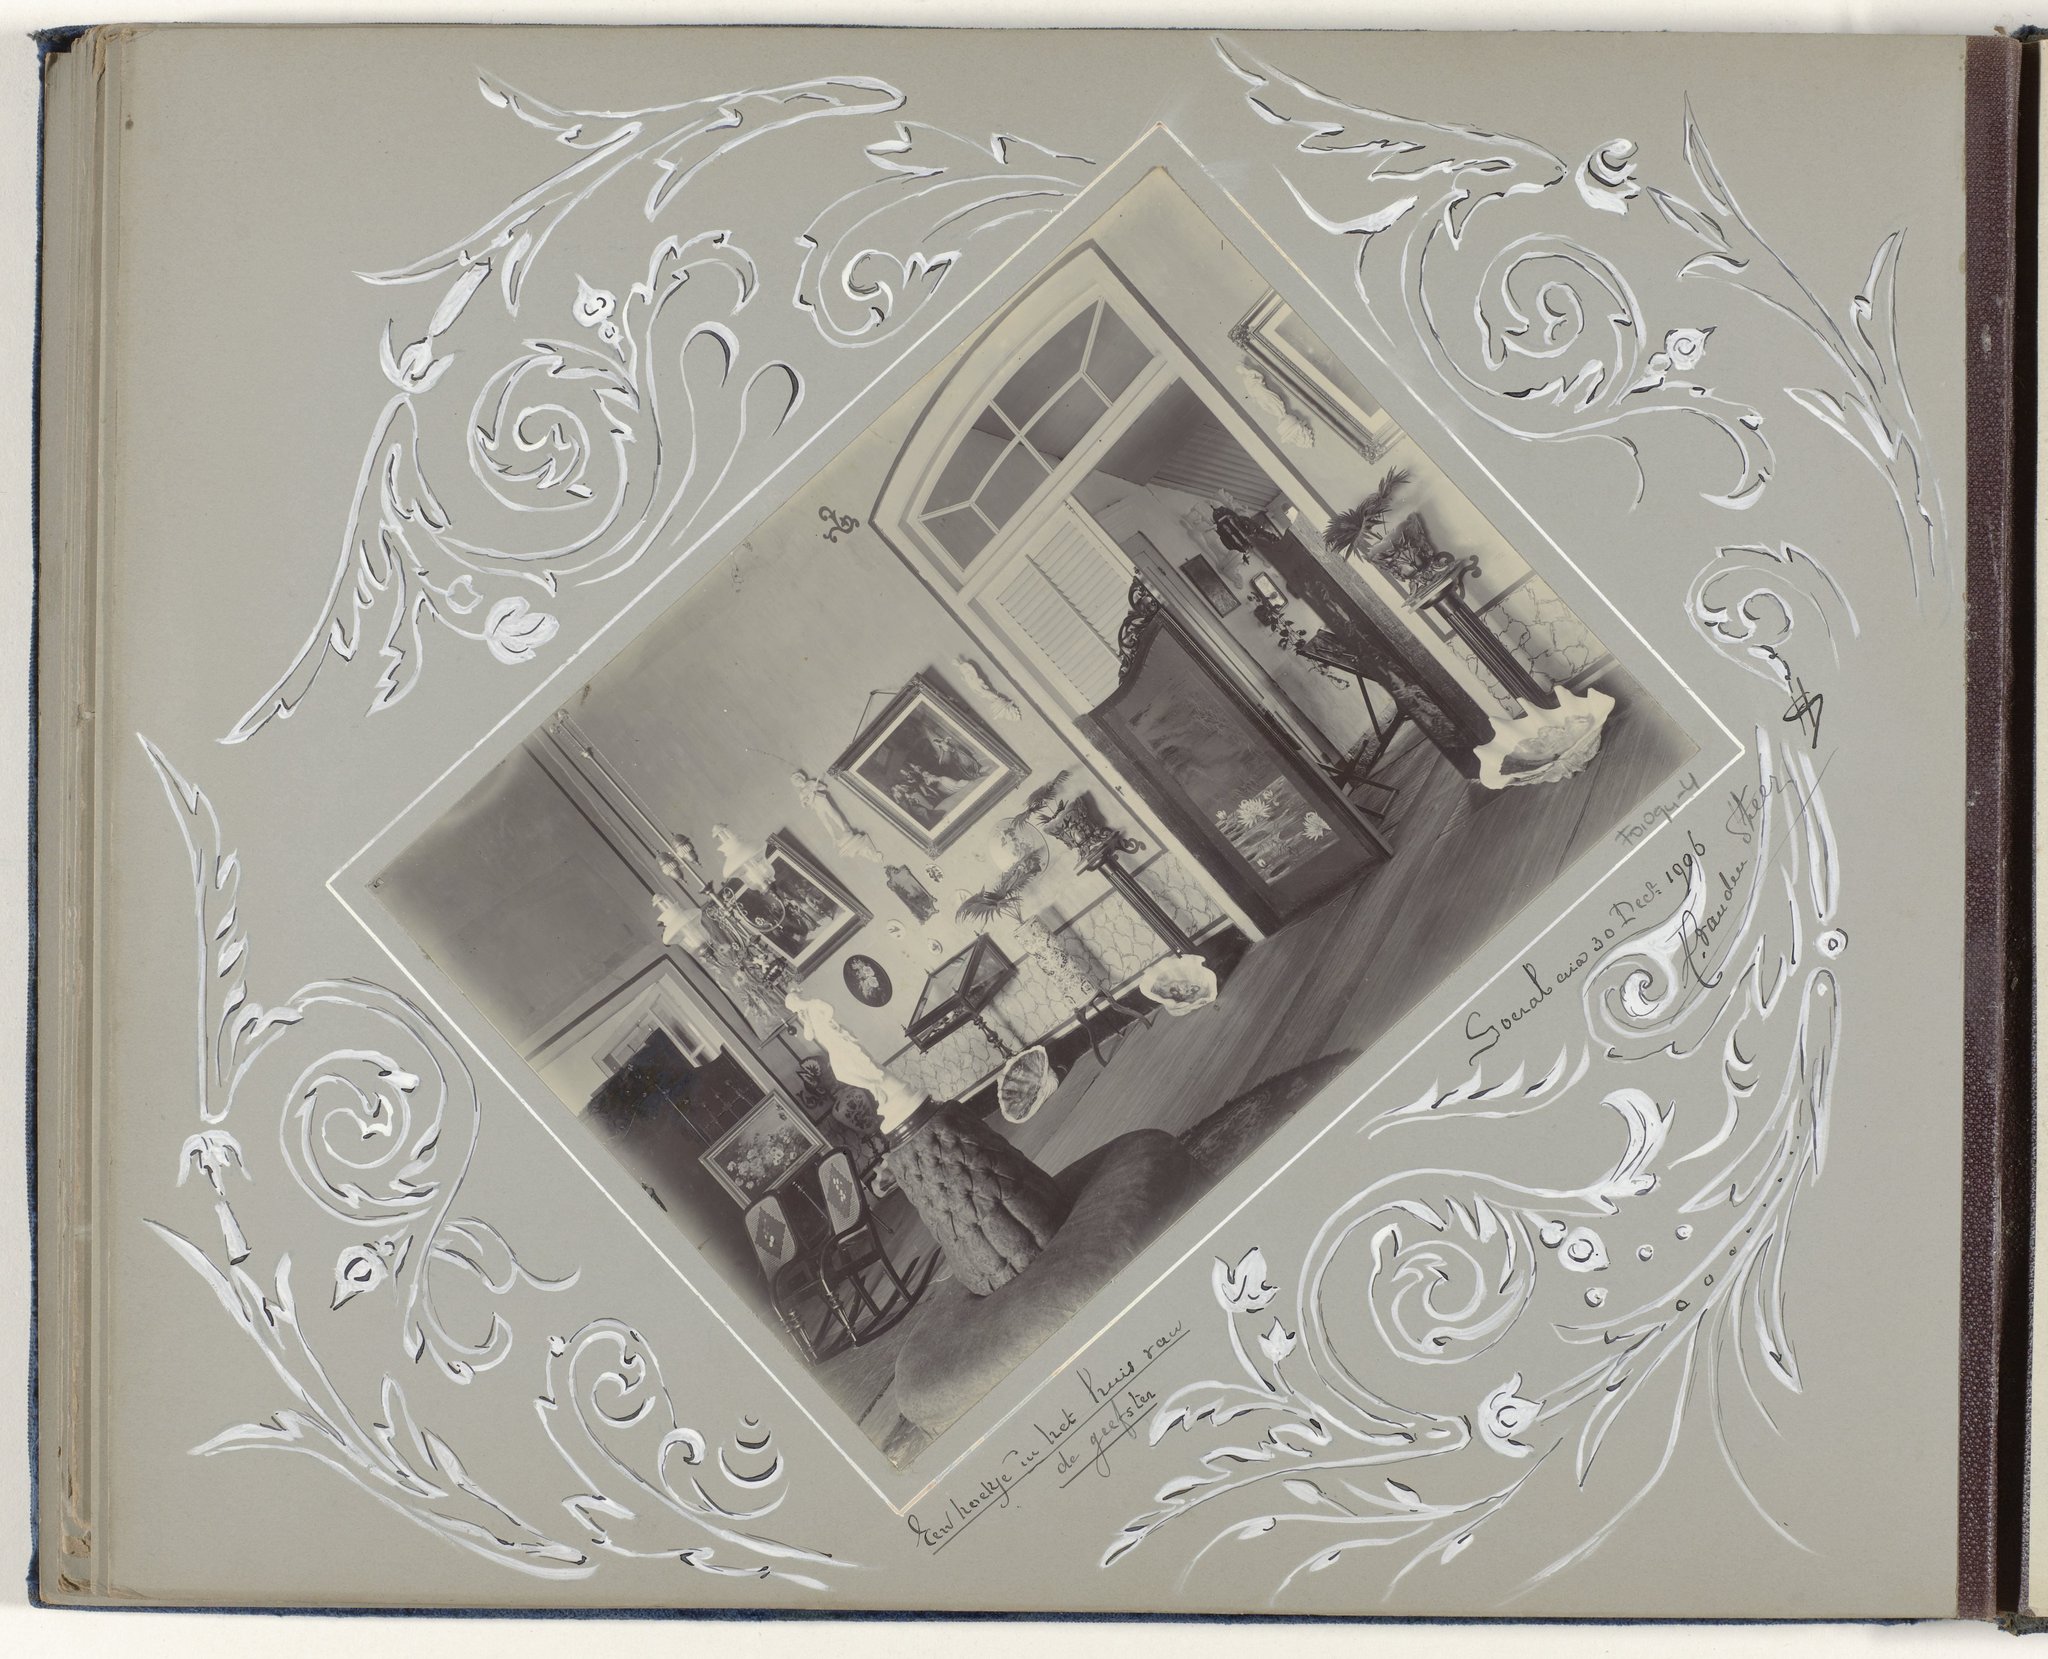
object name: photograph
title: Kamerinterieur in het huis van H. van den Steen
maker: Anonymous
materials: cardboard, paper, photographic support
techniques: gelatin silver print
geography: surabaya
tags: living-room, parlour, sitting-room, surabaya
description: Onderdeel van Herinneringsalbum met foto's van Soerabaja.